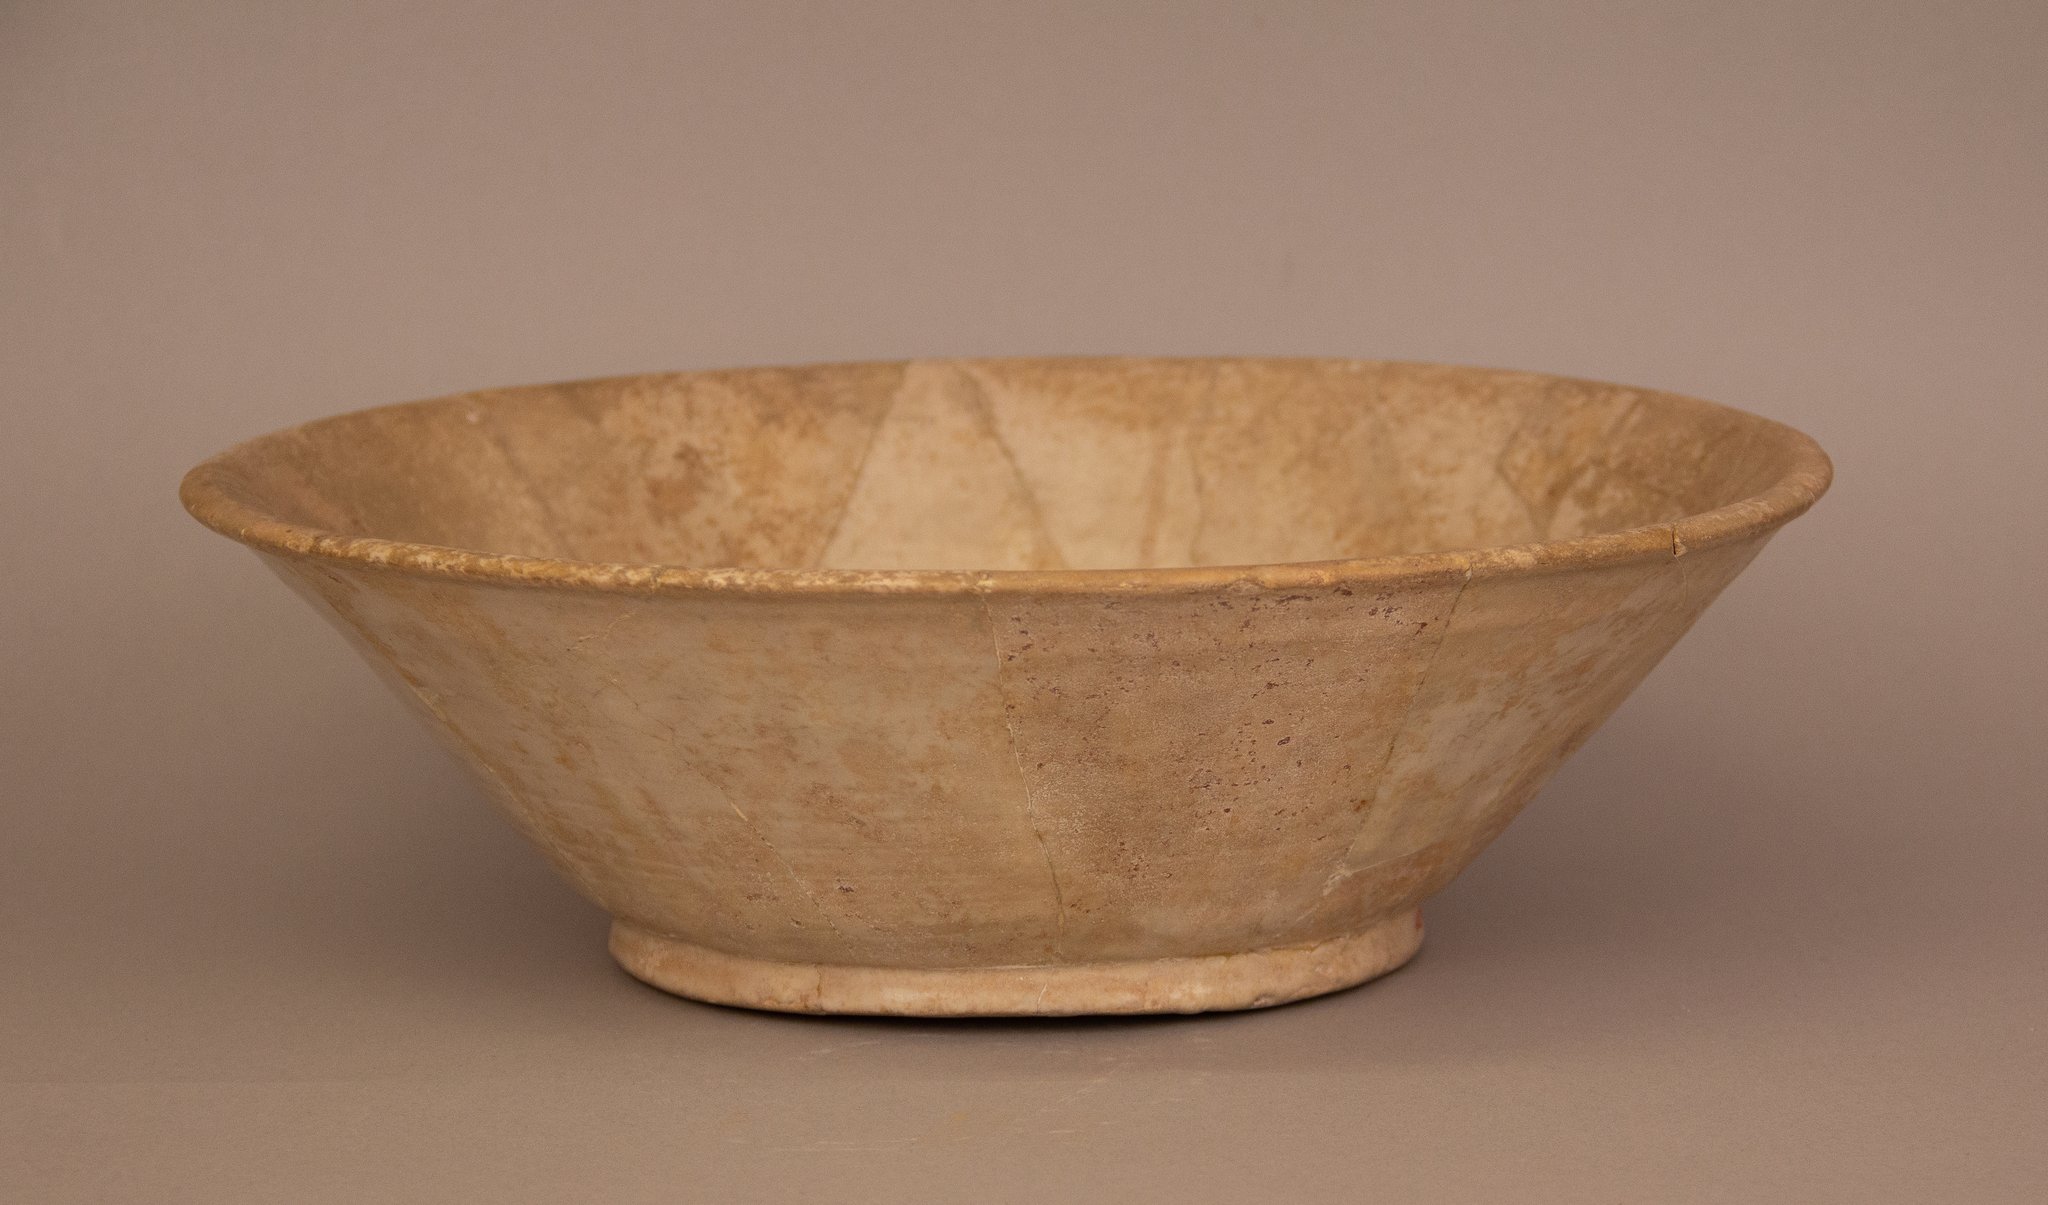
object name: bowl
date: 801-1000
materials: earthenware, glaze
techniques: molding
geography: iran